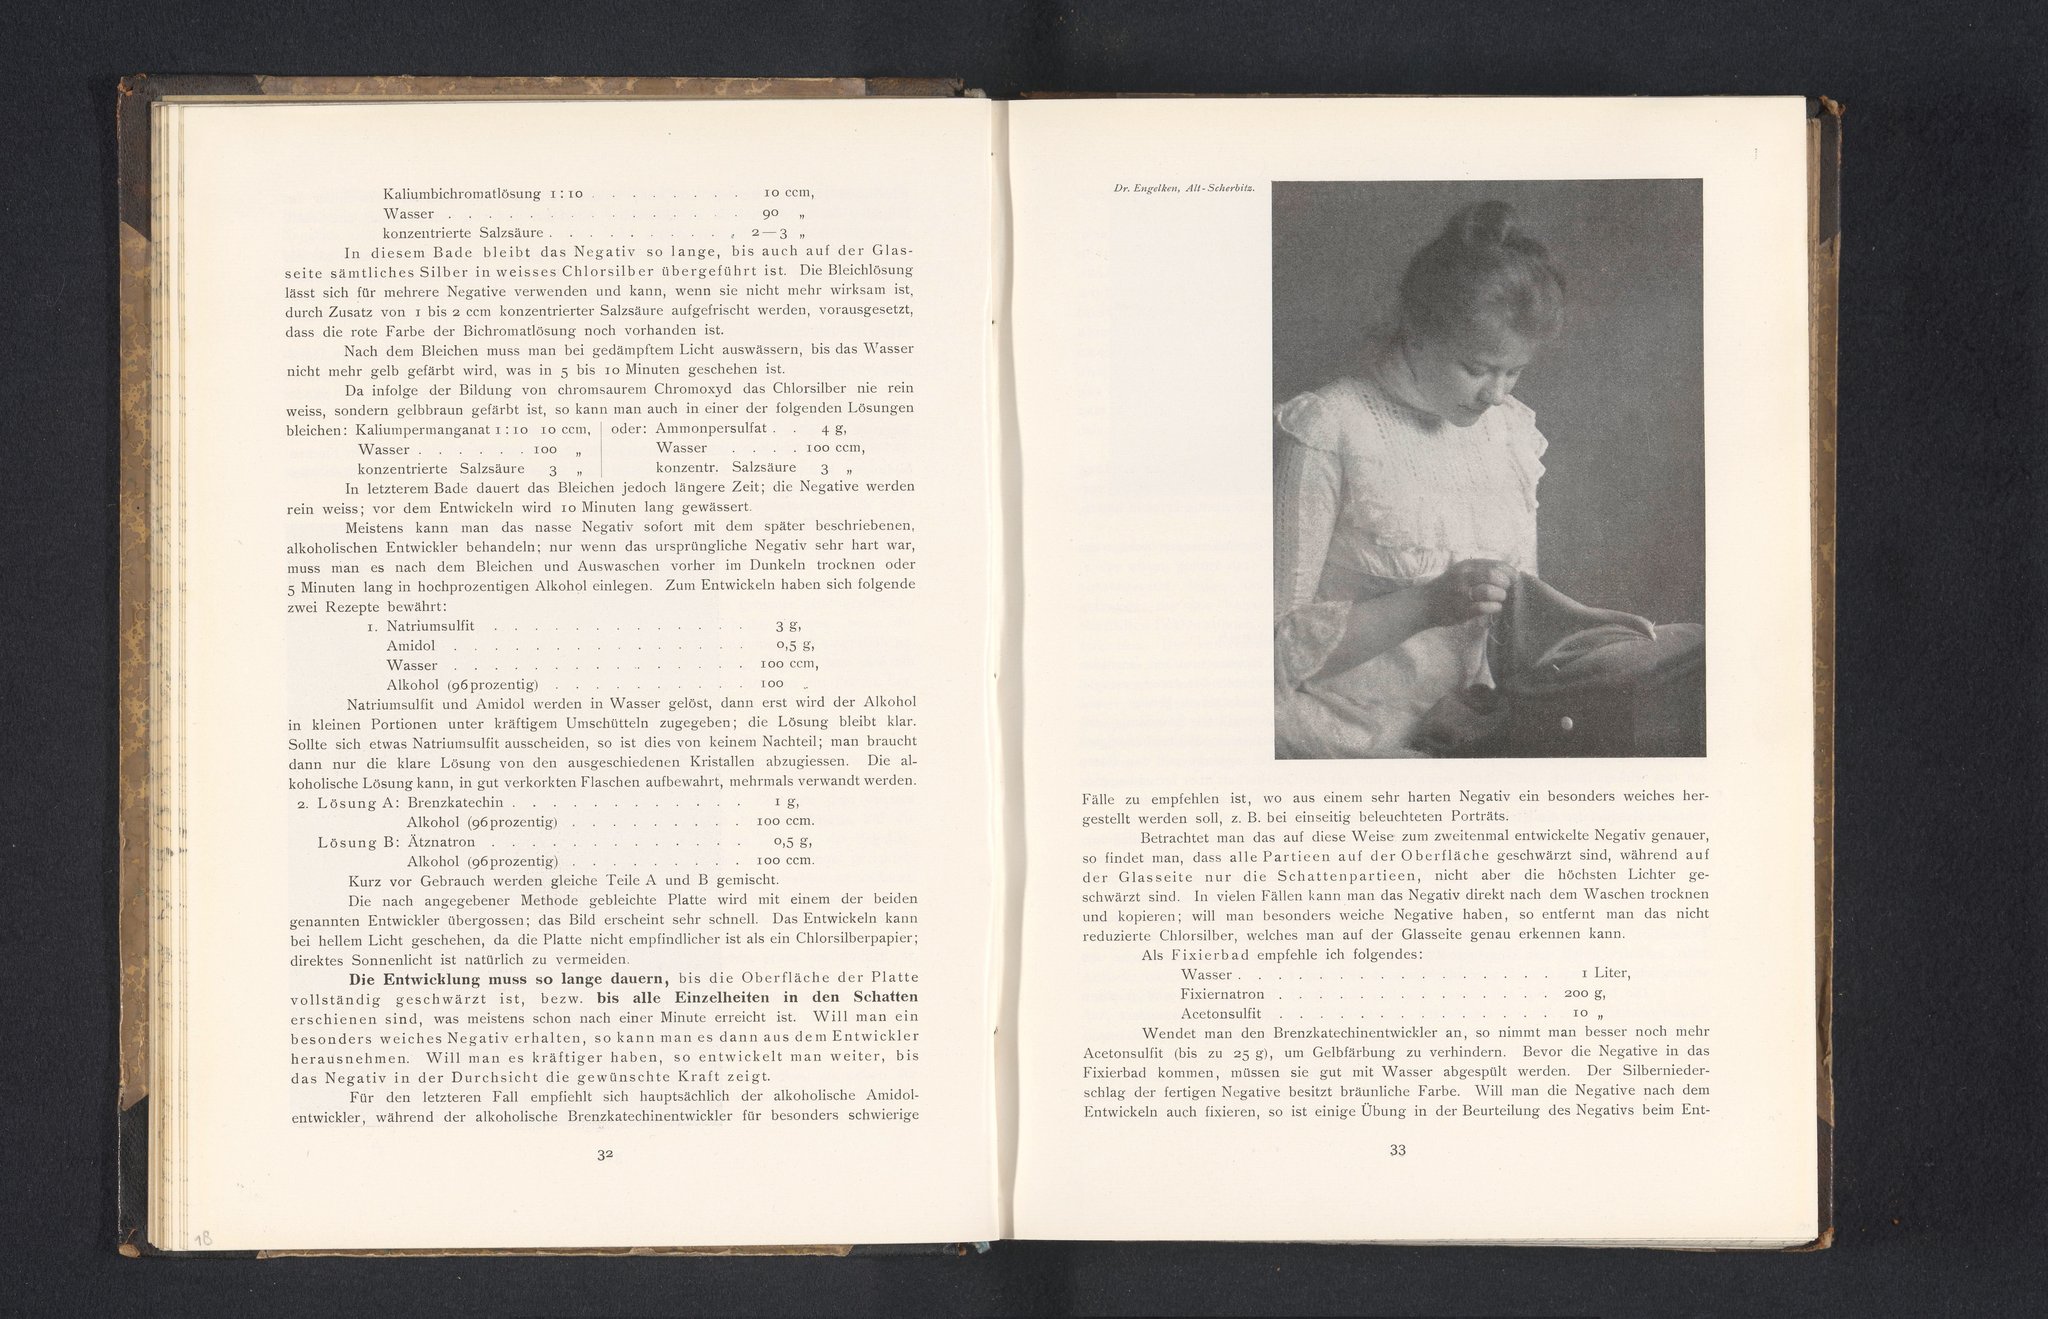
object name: page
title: Portret van een onbekende bordurende vrouw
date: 1898-1903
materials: paper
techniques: autotype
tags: historical persons not known by name - bb - woman, (other forms of) needlework, e.g.: crocheting, knitting, embroidering